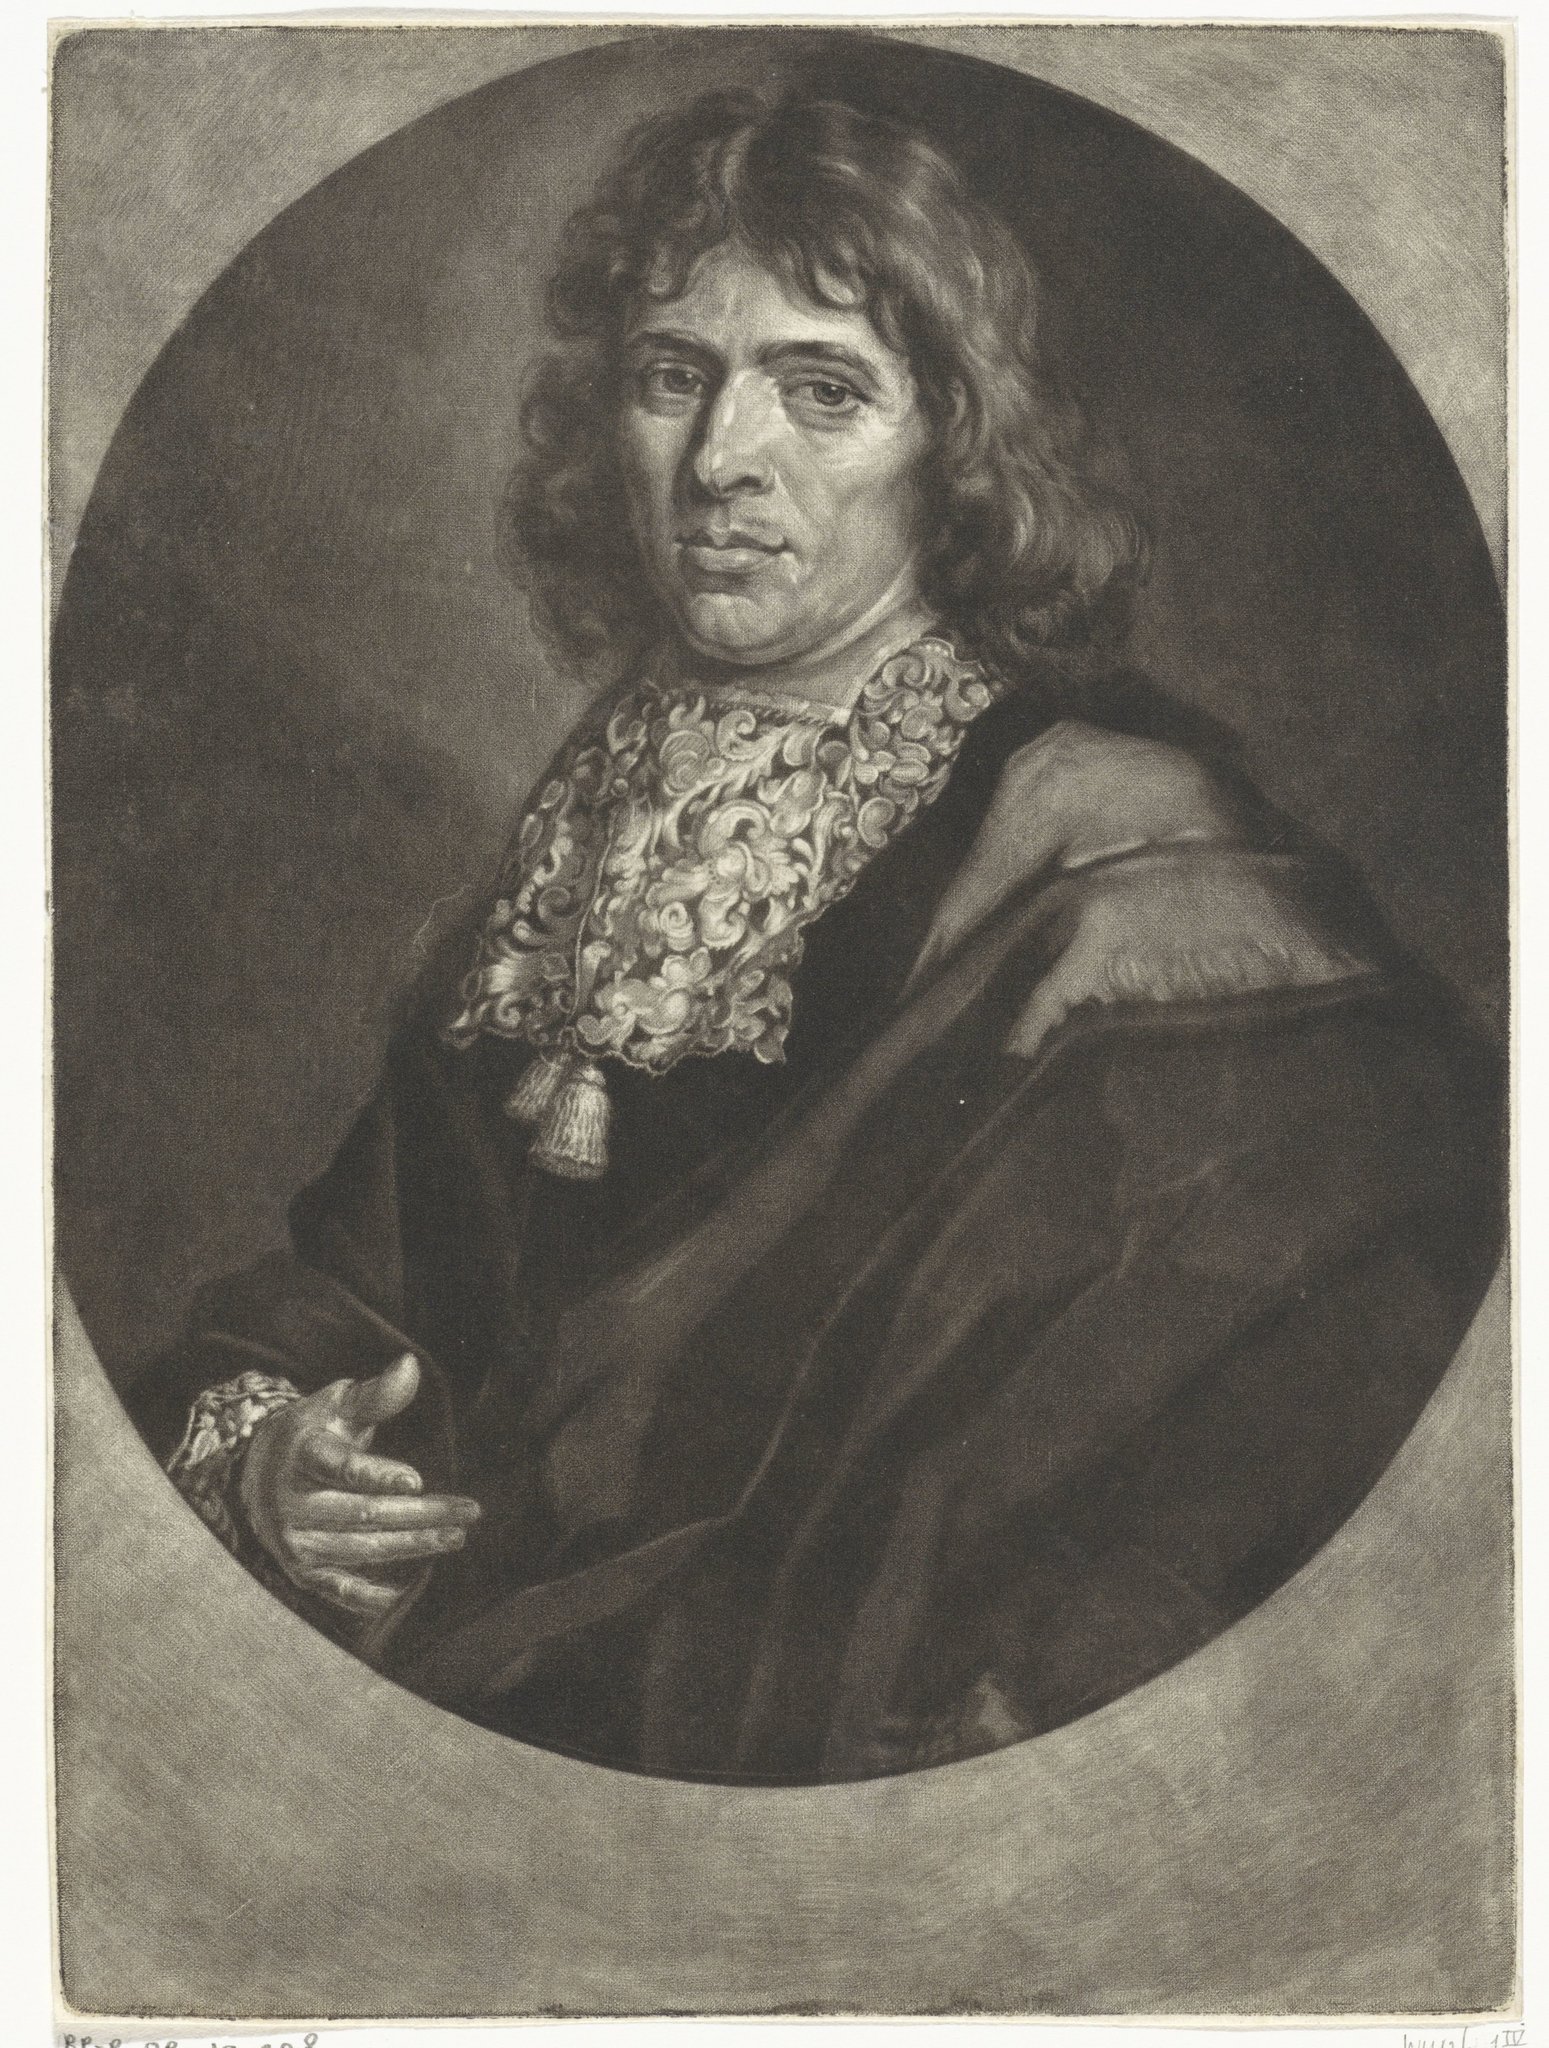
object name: print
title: Portret van Adriaan Dortsman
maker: pieter van der plas (ii)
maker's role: print maker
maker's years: 1647-1708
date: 1687-1708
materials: paper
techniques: mezzotint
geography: amsterdam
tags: flushing, adriaan dortsman, portrait, self-portrait of architect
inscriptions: collector's mark: Lugt 2228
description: De architect Adriaan Dortsman met een kraag van kant. Dortsman was verantwoordelijk voor het ontwerp van diverse bouwwerken in Amsterdam, waaronder de ronde Lutherse Kerk aan het Singel.